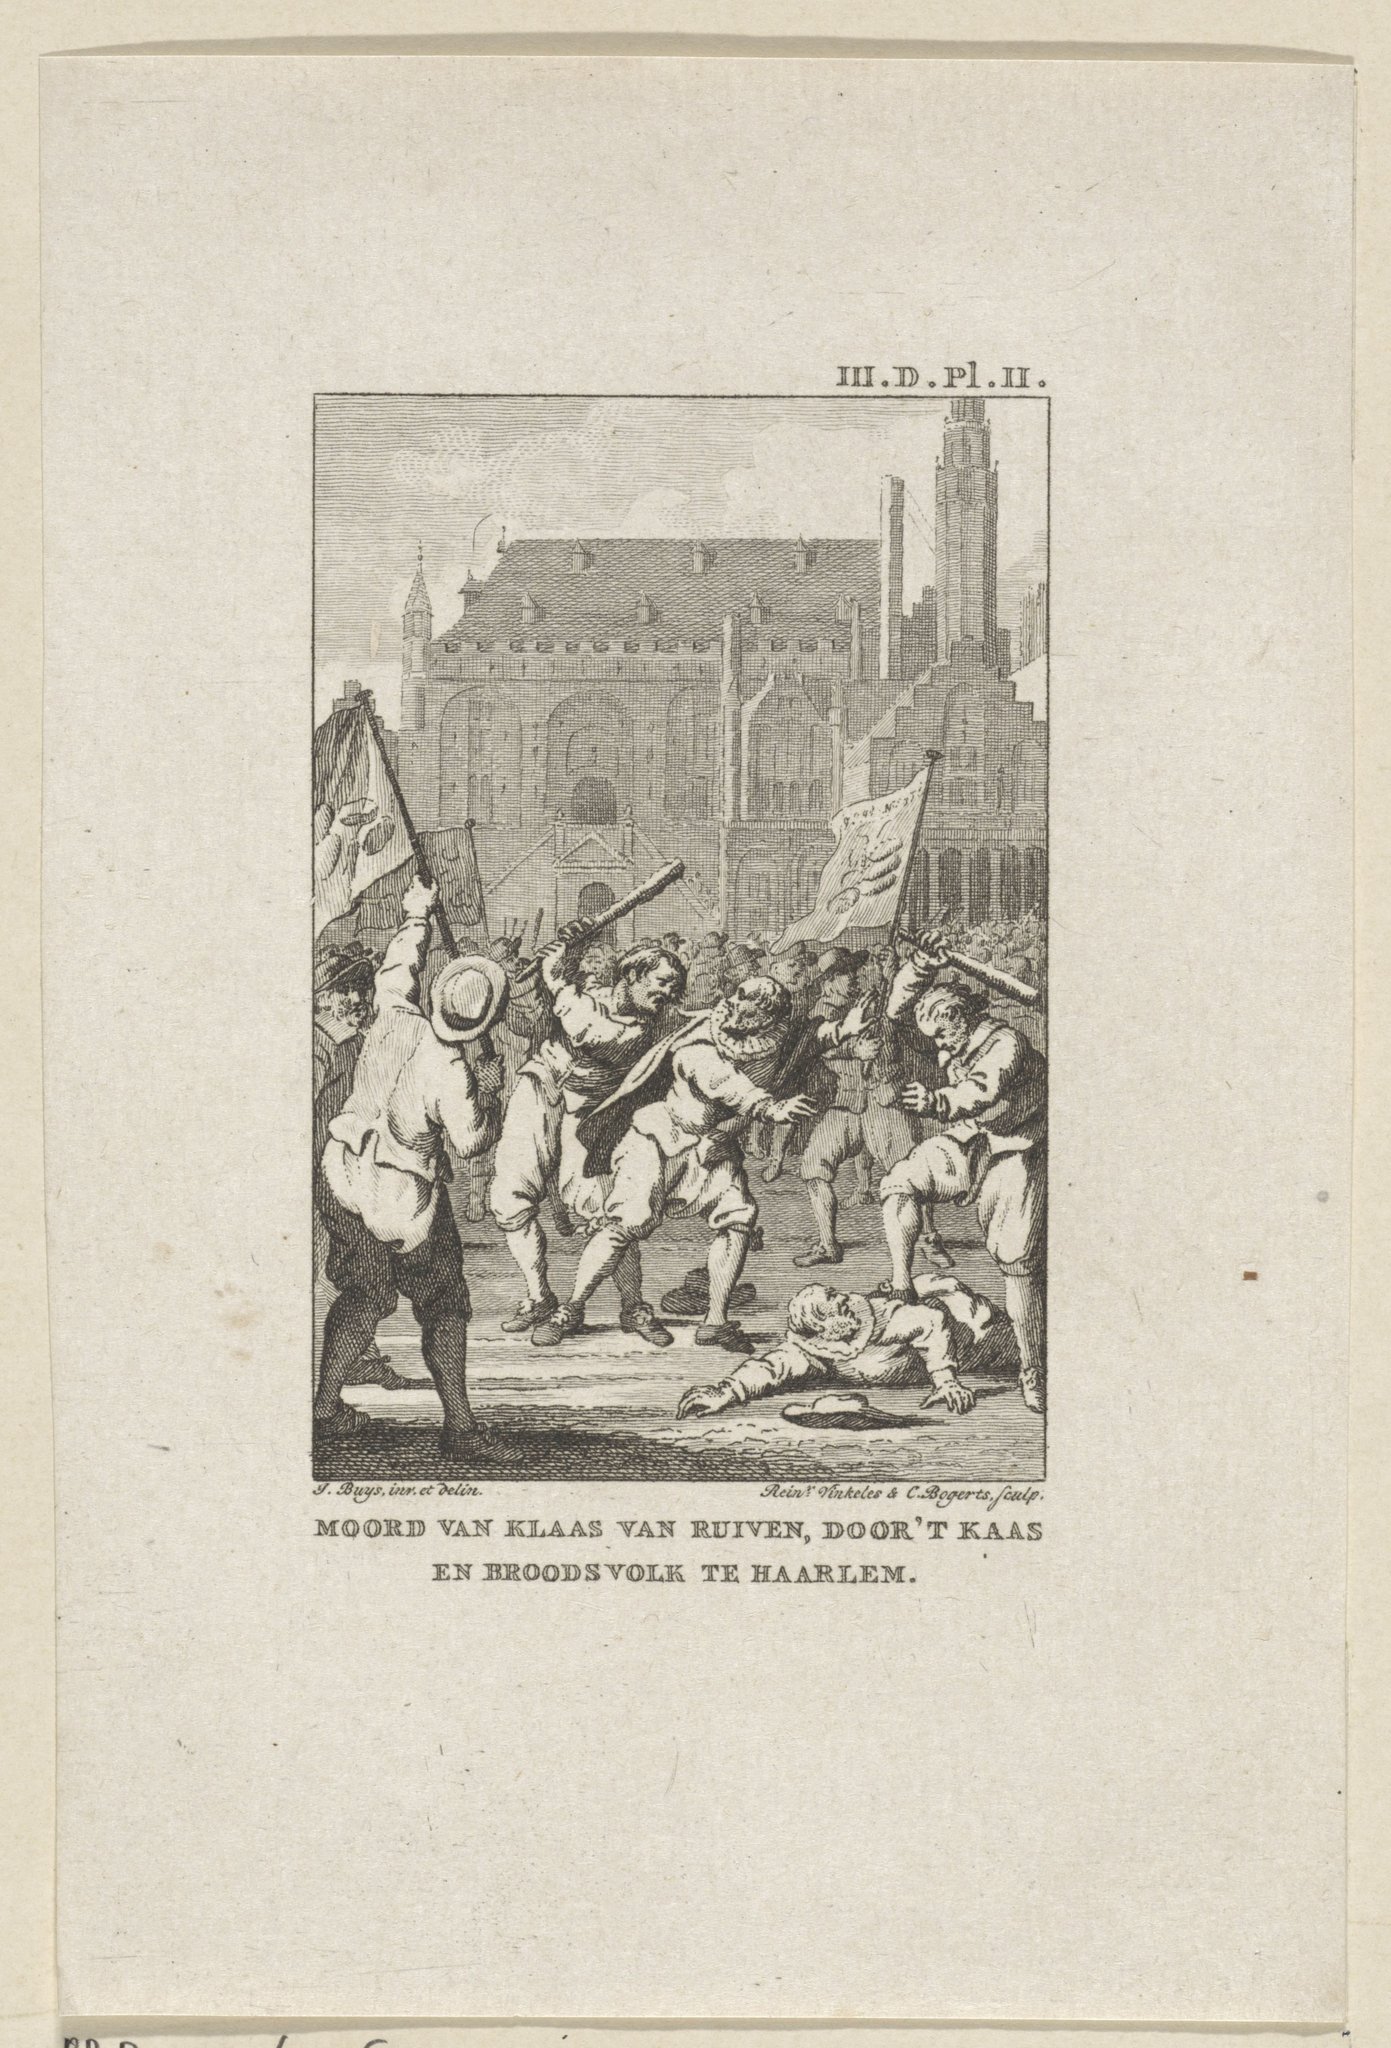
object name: book illustration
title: Moord van Klaas van Ruiven, door 't kaas en broodsvolk te Haarlem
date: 1783-1795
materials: paper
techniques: etching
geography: amsterdam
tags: haarlem, violent death, being killed; being mishandled and maltreated; seeking death, street-fights, riots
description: Illustratie voor: J. Fokke. Geschiedenissen der Vereenigde Nederlanden voor de vaderlandsche jeugd. Amsterdam: Johannes Allart, 1783-1795, 25 delen. deel III pl. II.